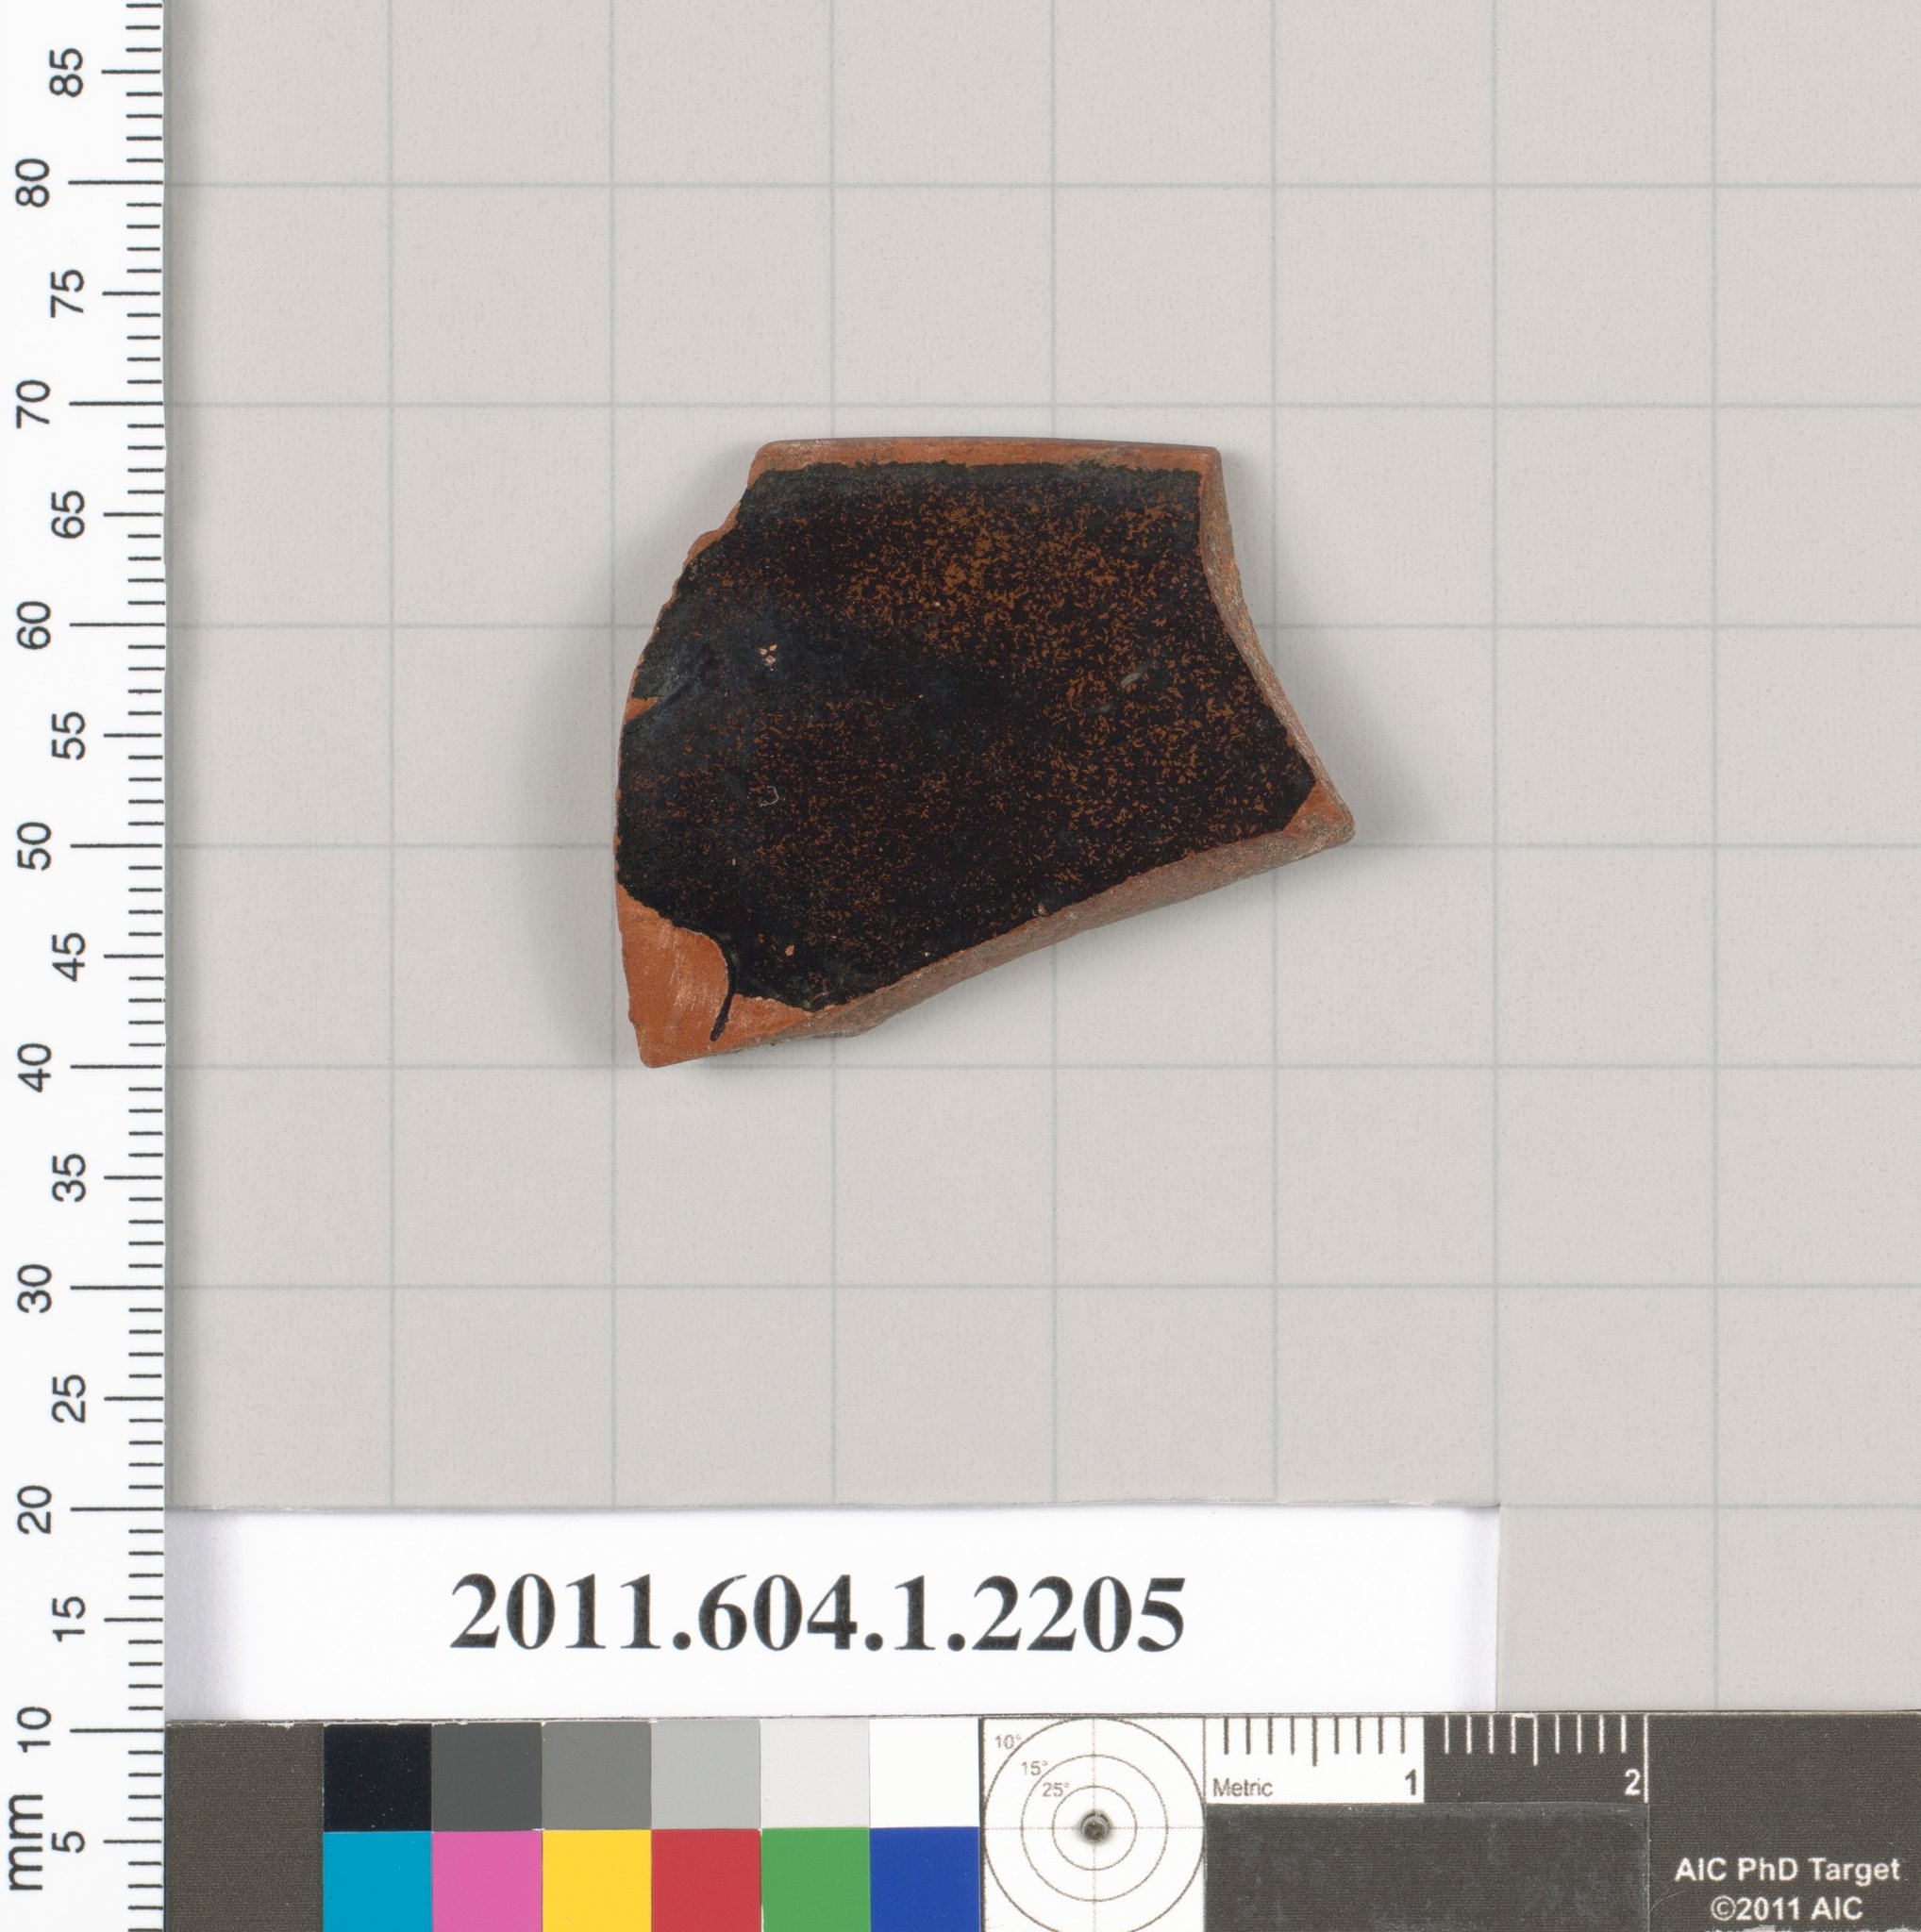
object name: kylix fragment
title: Terracotta rim fragment of a kylix (drinking cup)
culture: greek, attic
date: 475-451 BCE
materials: terracotta